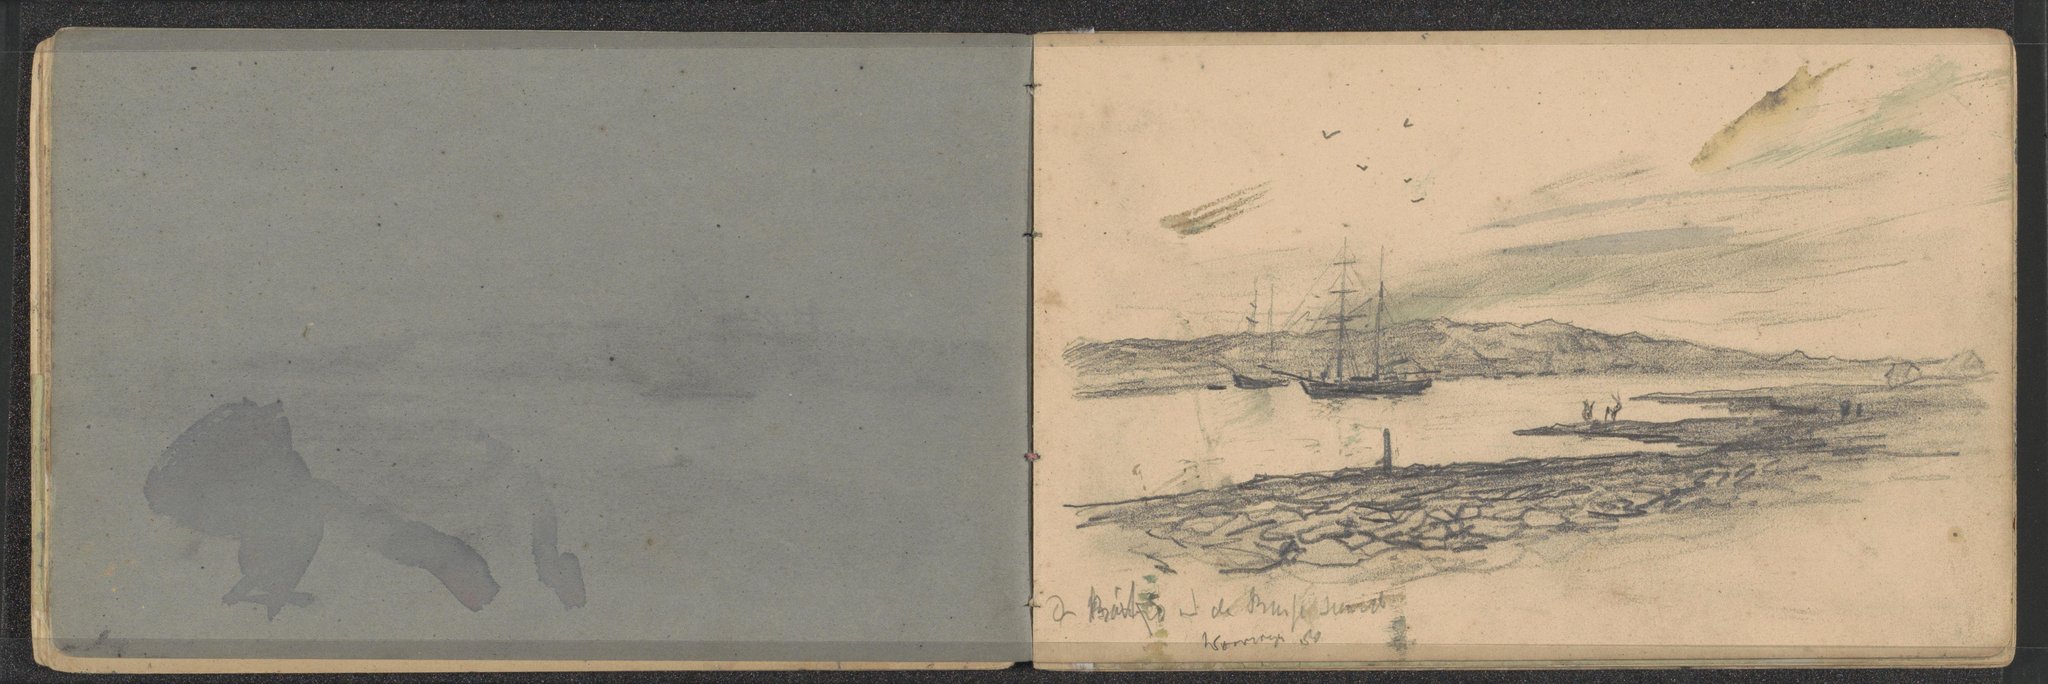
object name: sketchbook leaf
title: Gezicht op de Bussesundet met twee schepen, waaronder de Willem Barents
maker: louis apol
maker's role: draughtsman, painter, print maker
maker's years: 1850-1936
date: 1880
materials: chalk, paper, pencil, watercolor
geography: vardø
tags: coast (in polar regions), ships (in general)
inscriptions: annotation: ‘de Barents[?] uit[?] de Bussesundet/ [...]’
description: Blad 19 recto uit een schetsboek met 35 bladen betekend tijdens de expeditie naar Nova Zembla in 1880.